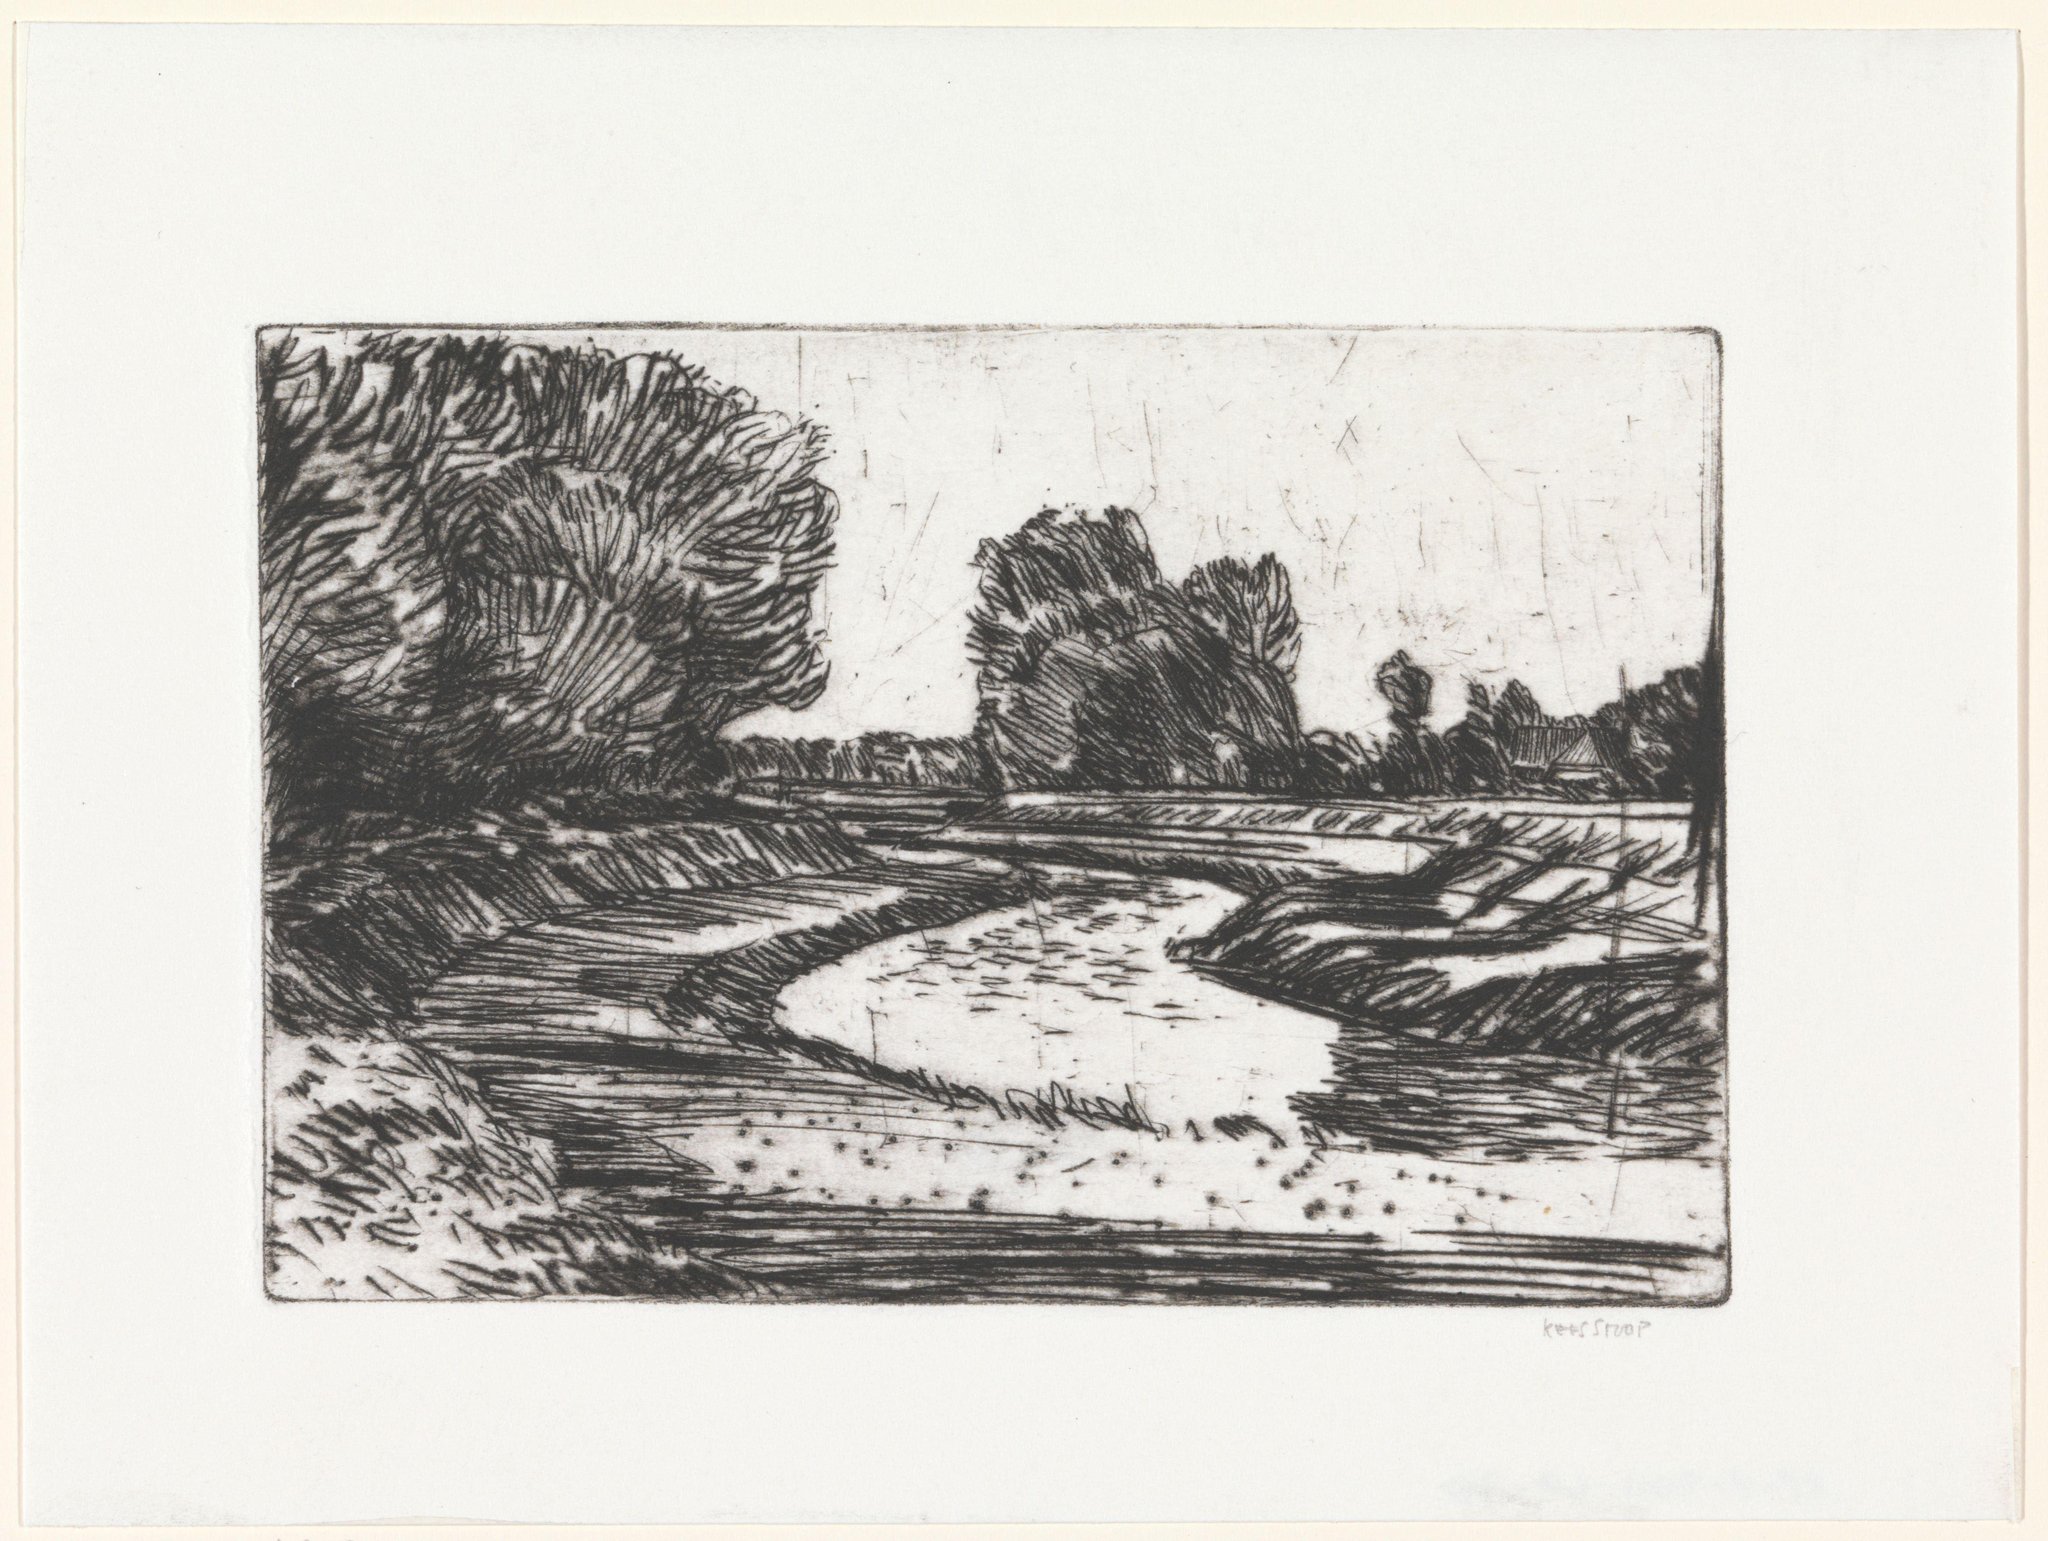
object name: print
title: Rivierbedding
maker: kees stoop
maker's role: draughtsman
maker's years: 1929-2019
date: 1944-1990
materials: paper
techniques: drypoint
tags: river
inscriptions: signature: ‘KEES STOOP’